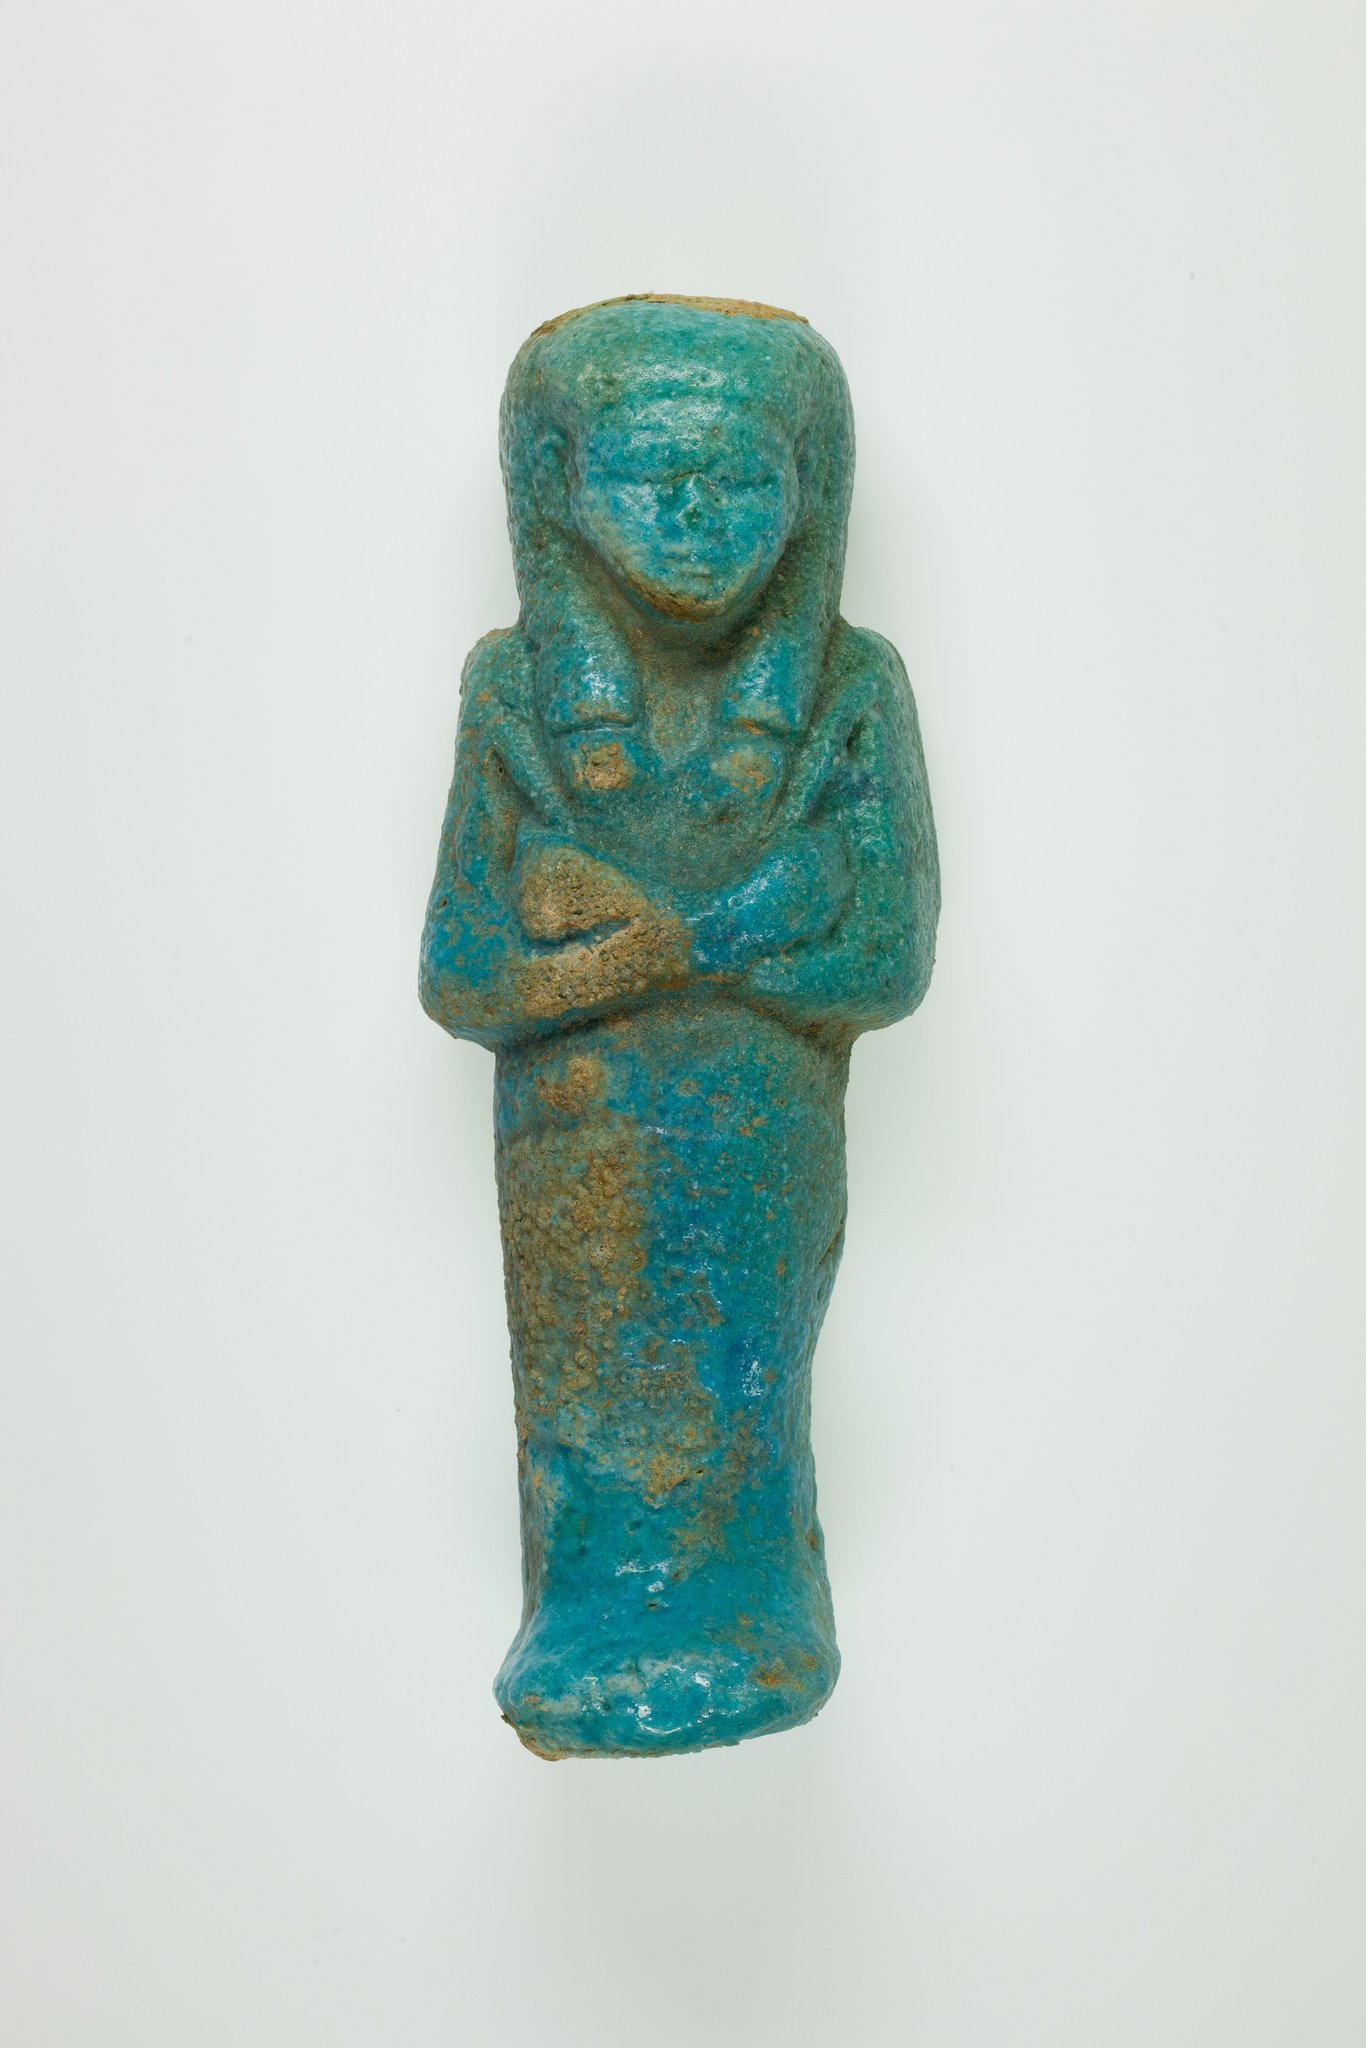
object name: worker shabti, henettawy c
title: Worker Shabti of Henettawy (C), Daughter of Isetemkheb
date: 990-970 BCE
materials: faience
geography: egypt